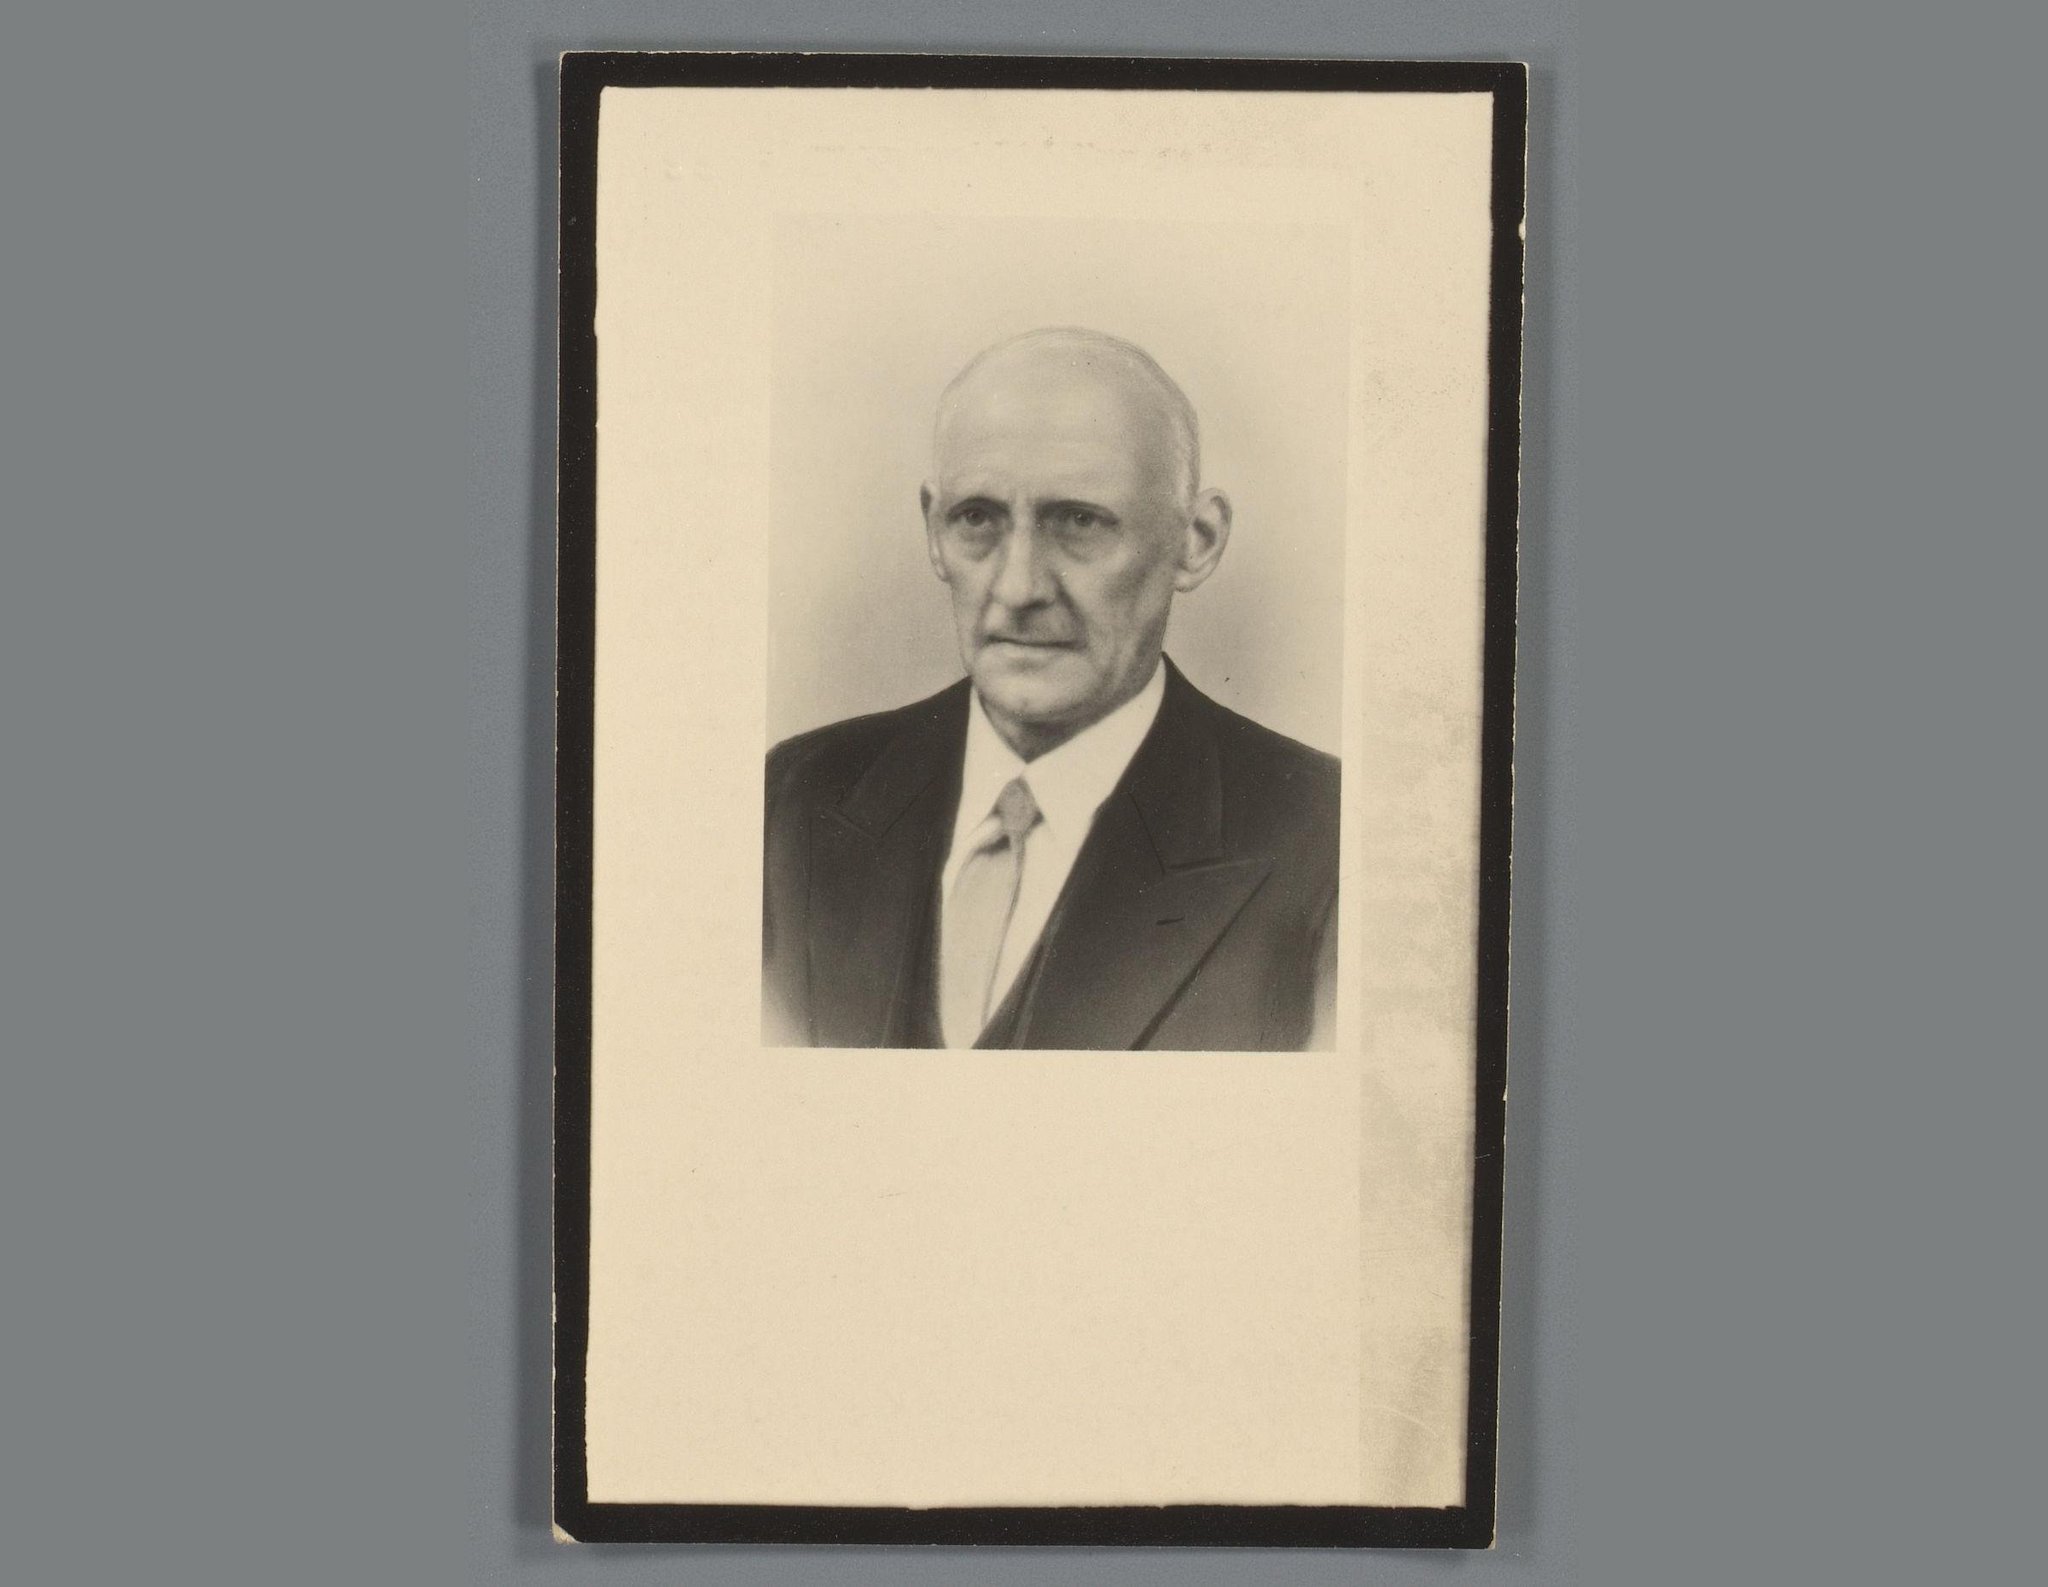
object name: prayer card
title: Portret van Cornelis Hendricus Willebrordus Zwinkels op bidprent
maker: Anonymous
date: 1961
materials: paper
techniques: gelatin silver print, letterpress printing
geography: naaldwijk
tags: historical persons, old man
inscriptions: inscription: ‘Laten wij bidden voor (...) een met elkaar en laten wij allen voor/ elkaar bidden.’